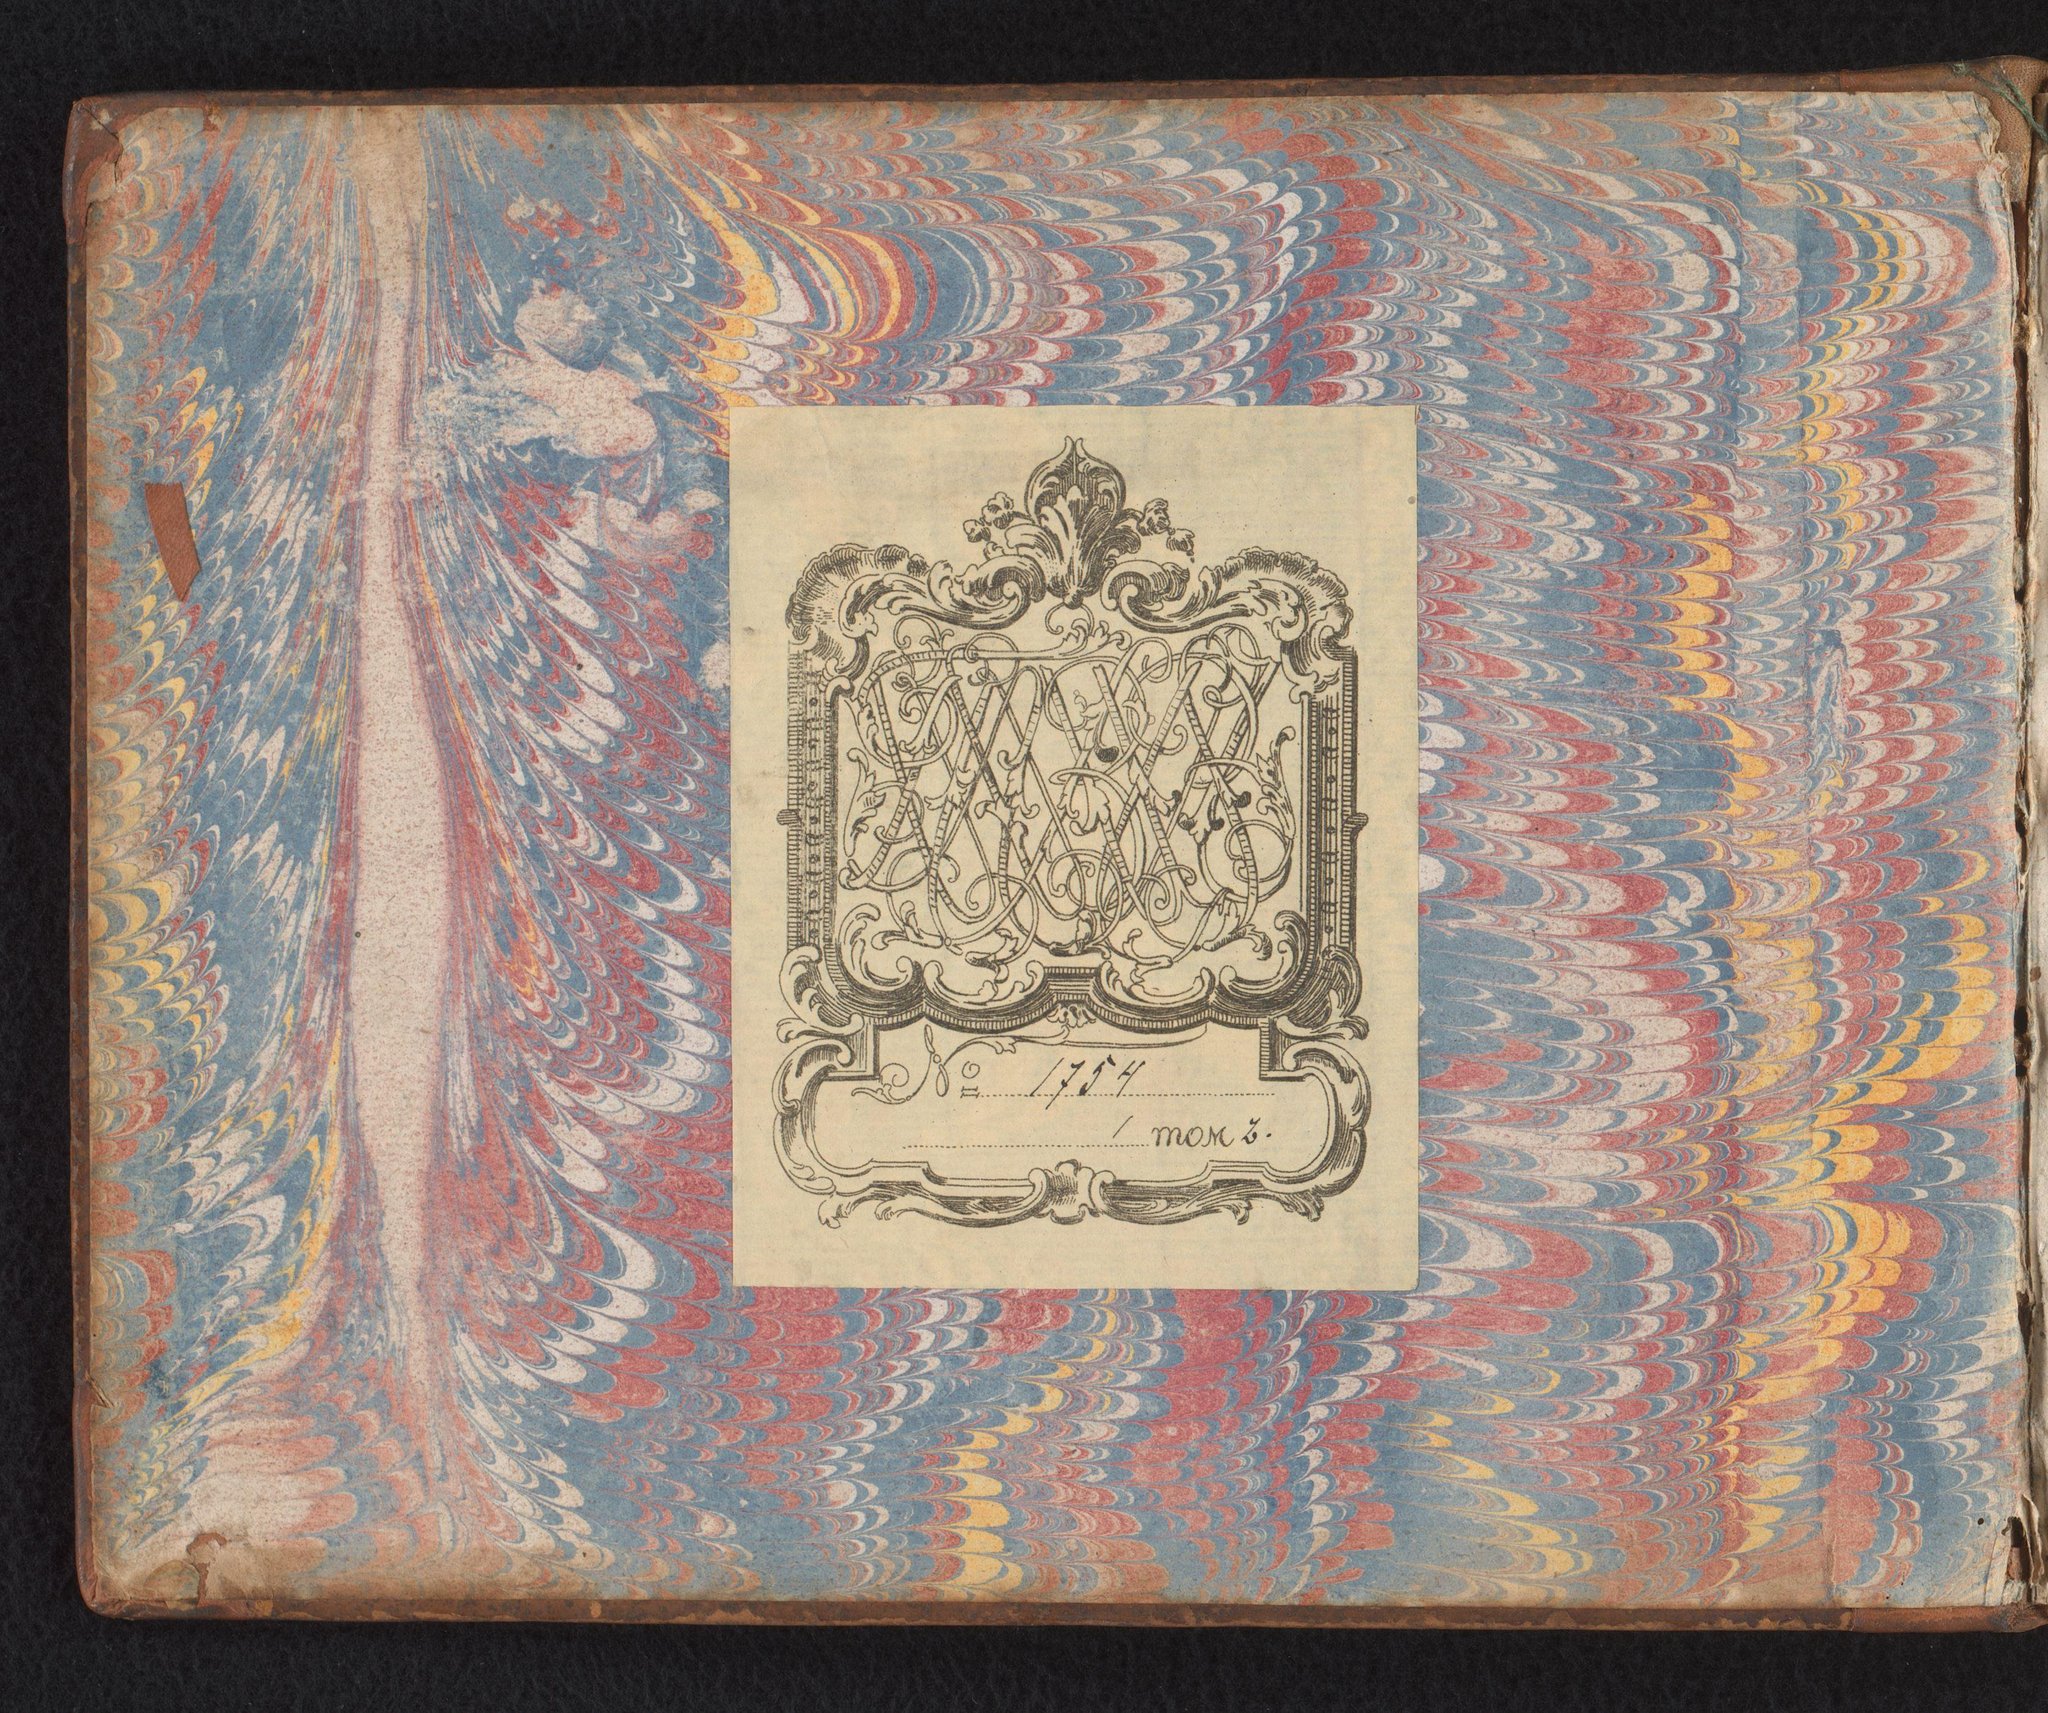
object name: album leaf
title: Ex libris met monogram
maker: Anonymous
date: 1650-1676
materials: paper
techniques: engraving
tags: letter combinations such as letterword, anagram, letter square, monogram, etc.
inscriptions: annotation: ‘1754’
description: Deze prent maakt deel uit van een album.